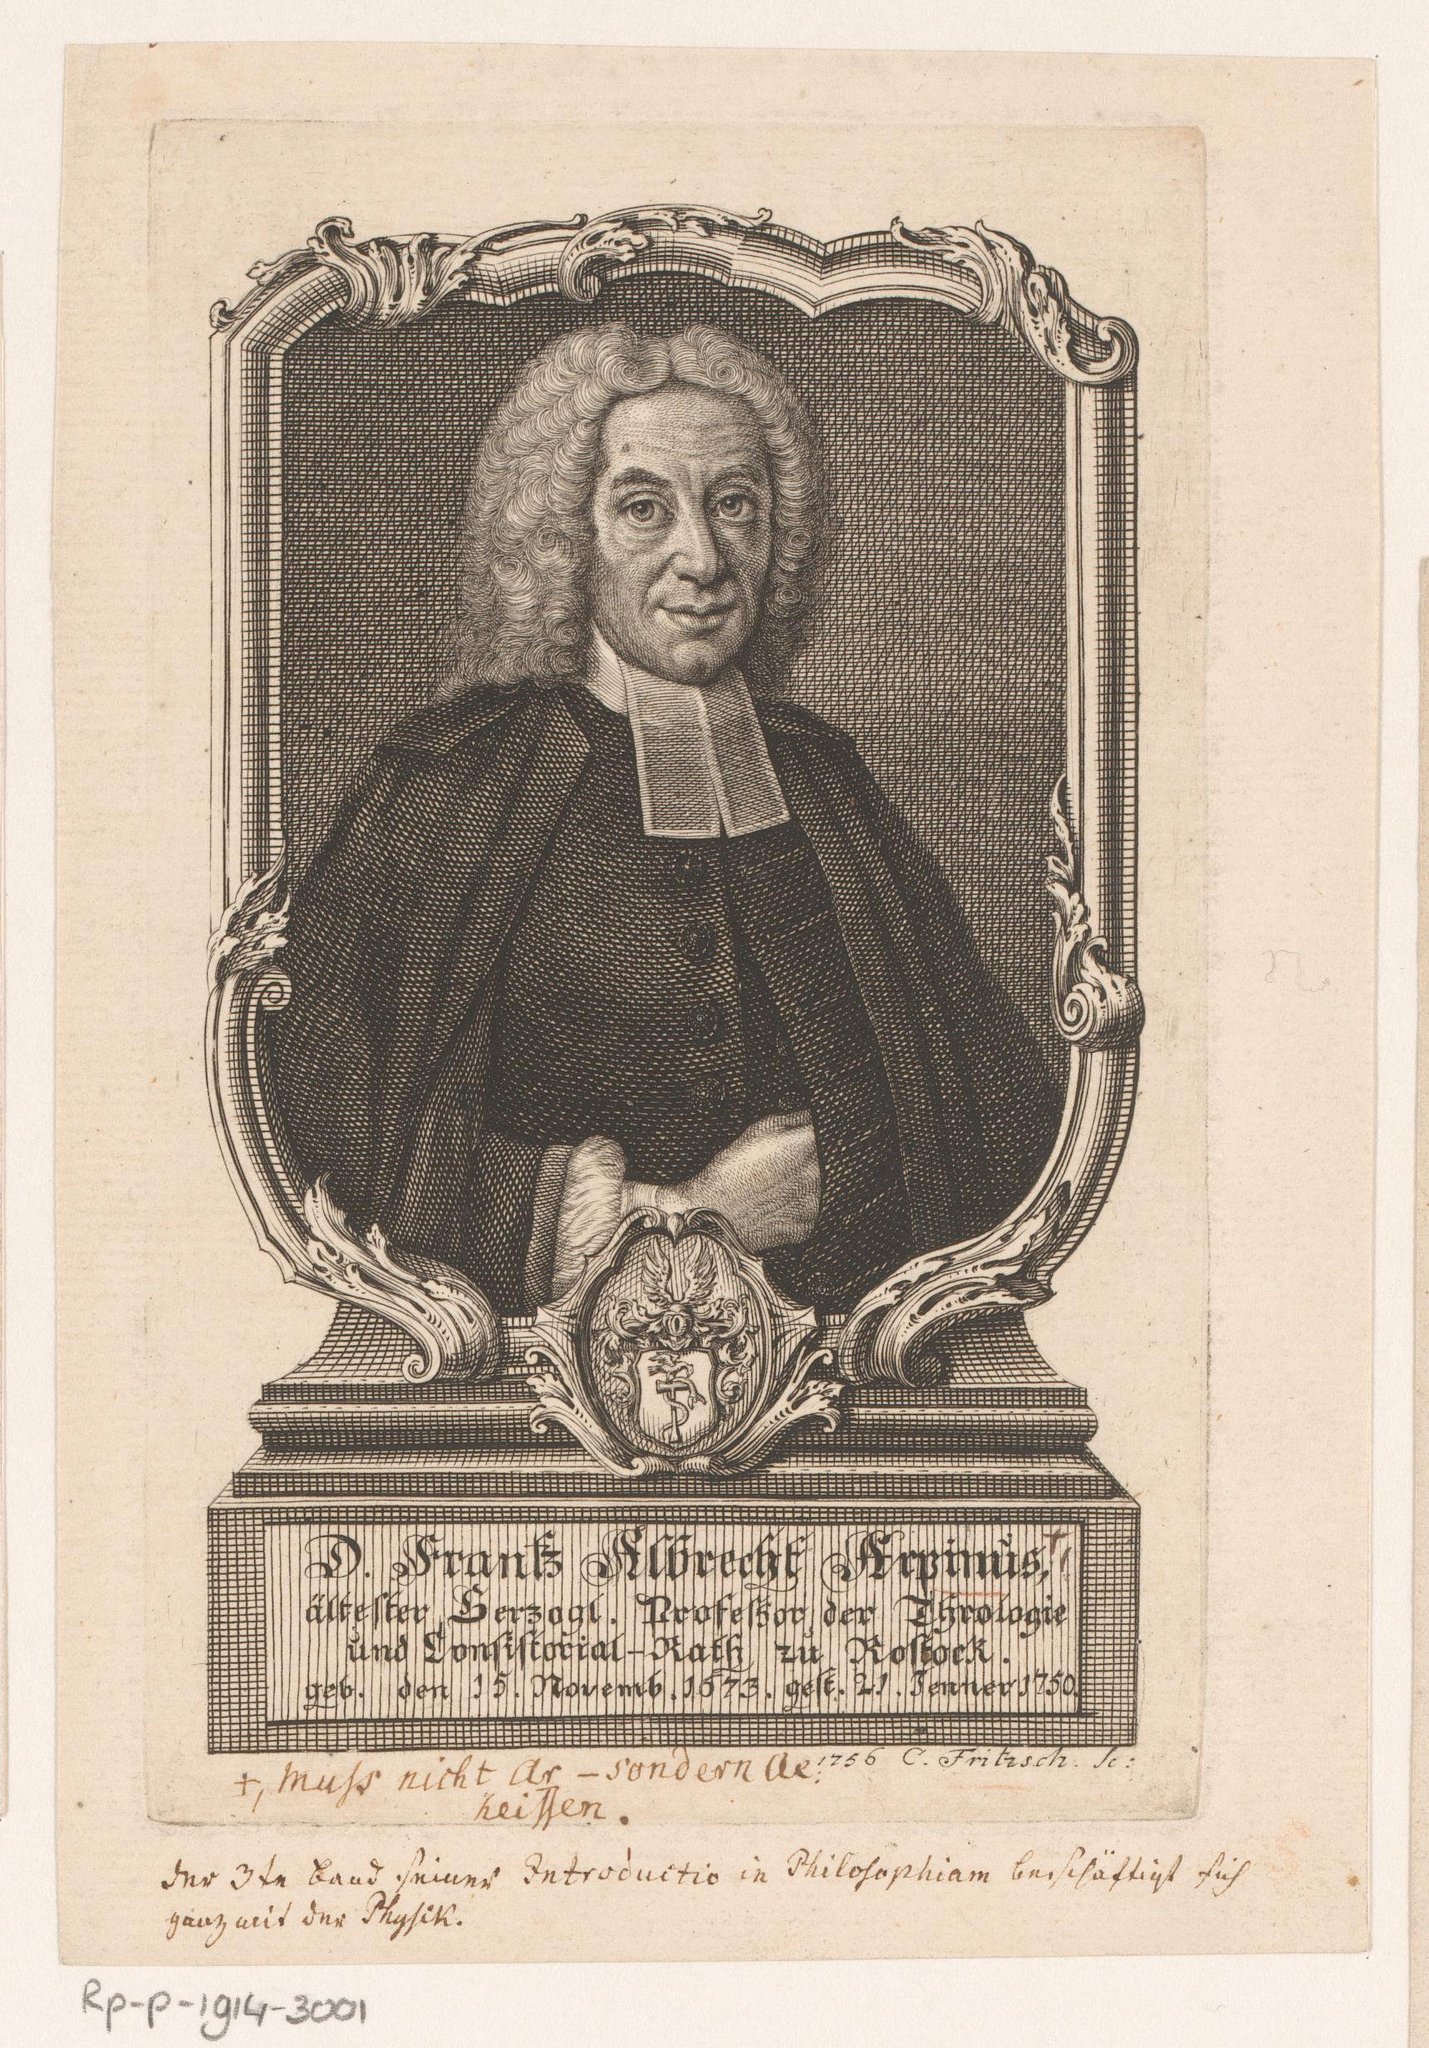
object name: print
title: Portret van Franz Albert Aepinus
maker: christian fritzsch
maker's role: print maker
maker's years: 1695-1769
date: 1756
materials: paper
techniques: engraving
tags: rocaille ornament, historical persons, armorial bearing, heraldry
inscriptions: inscription: ‘+, Muss nicht Ar - sondern Ae heissen.’, collector's mark: Lugt 2228